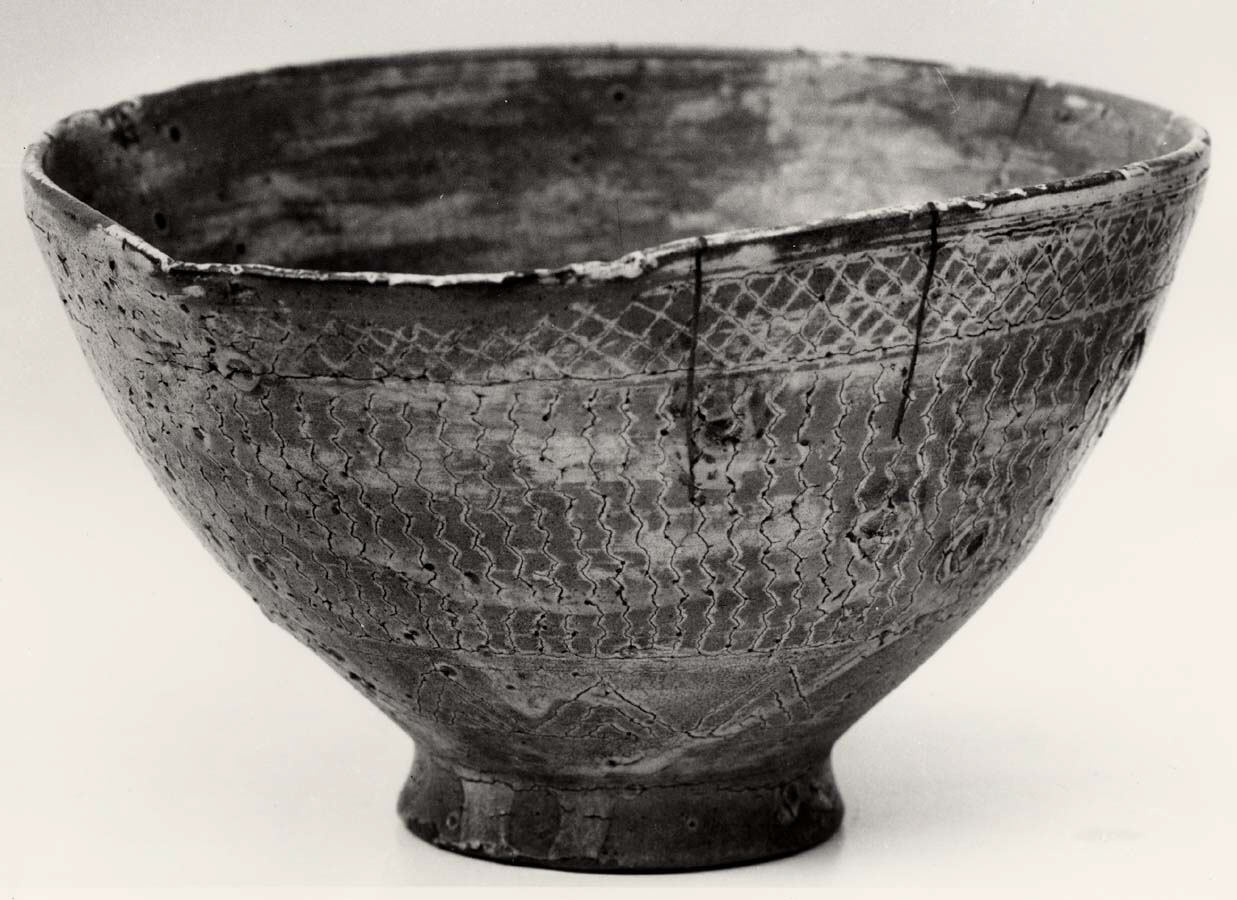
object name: bowl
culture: korean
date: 901-1400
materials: pottery